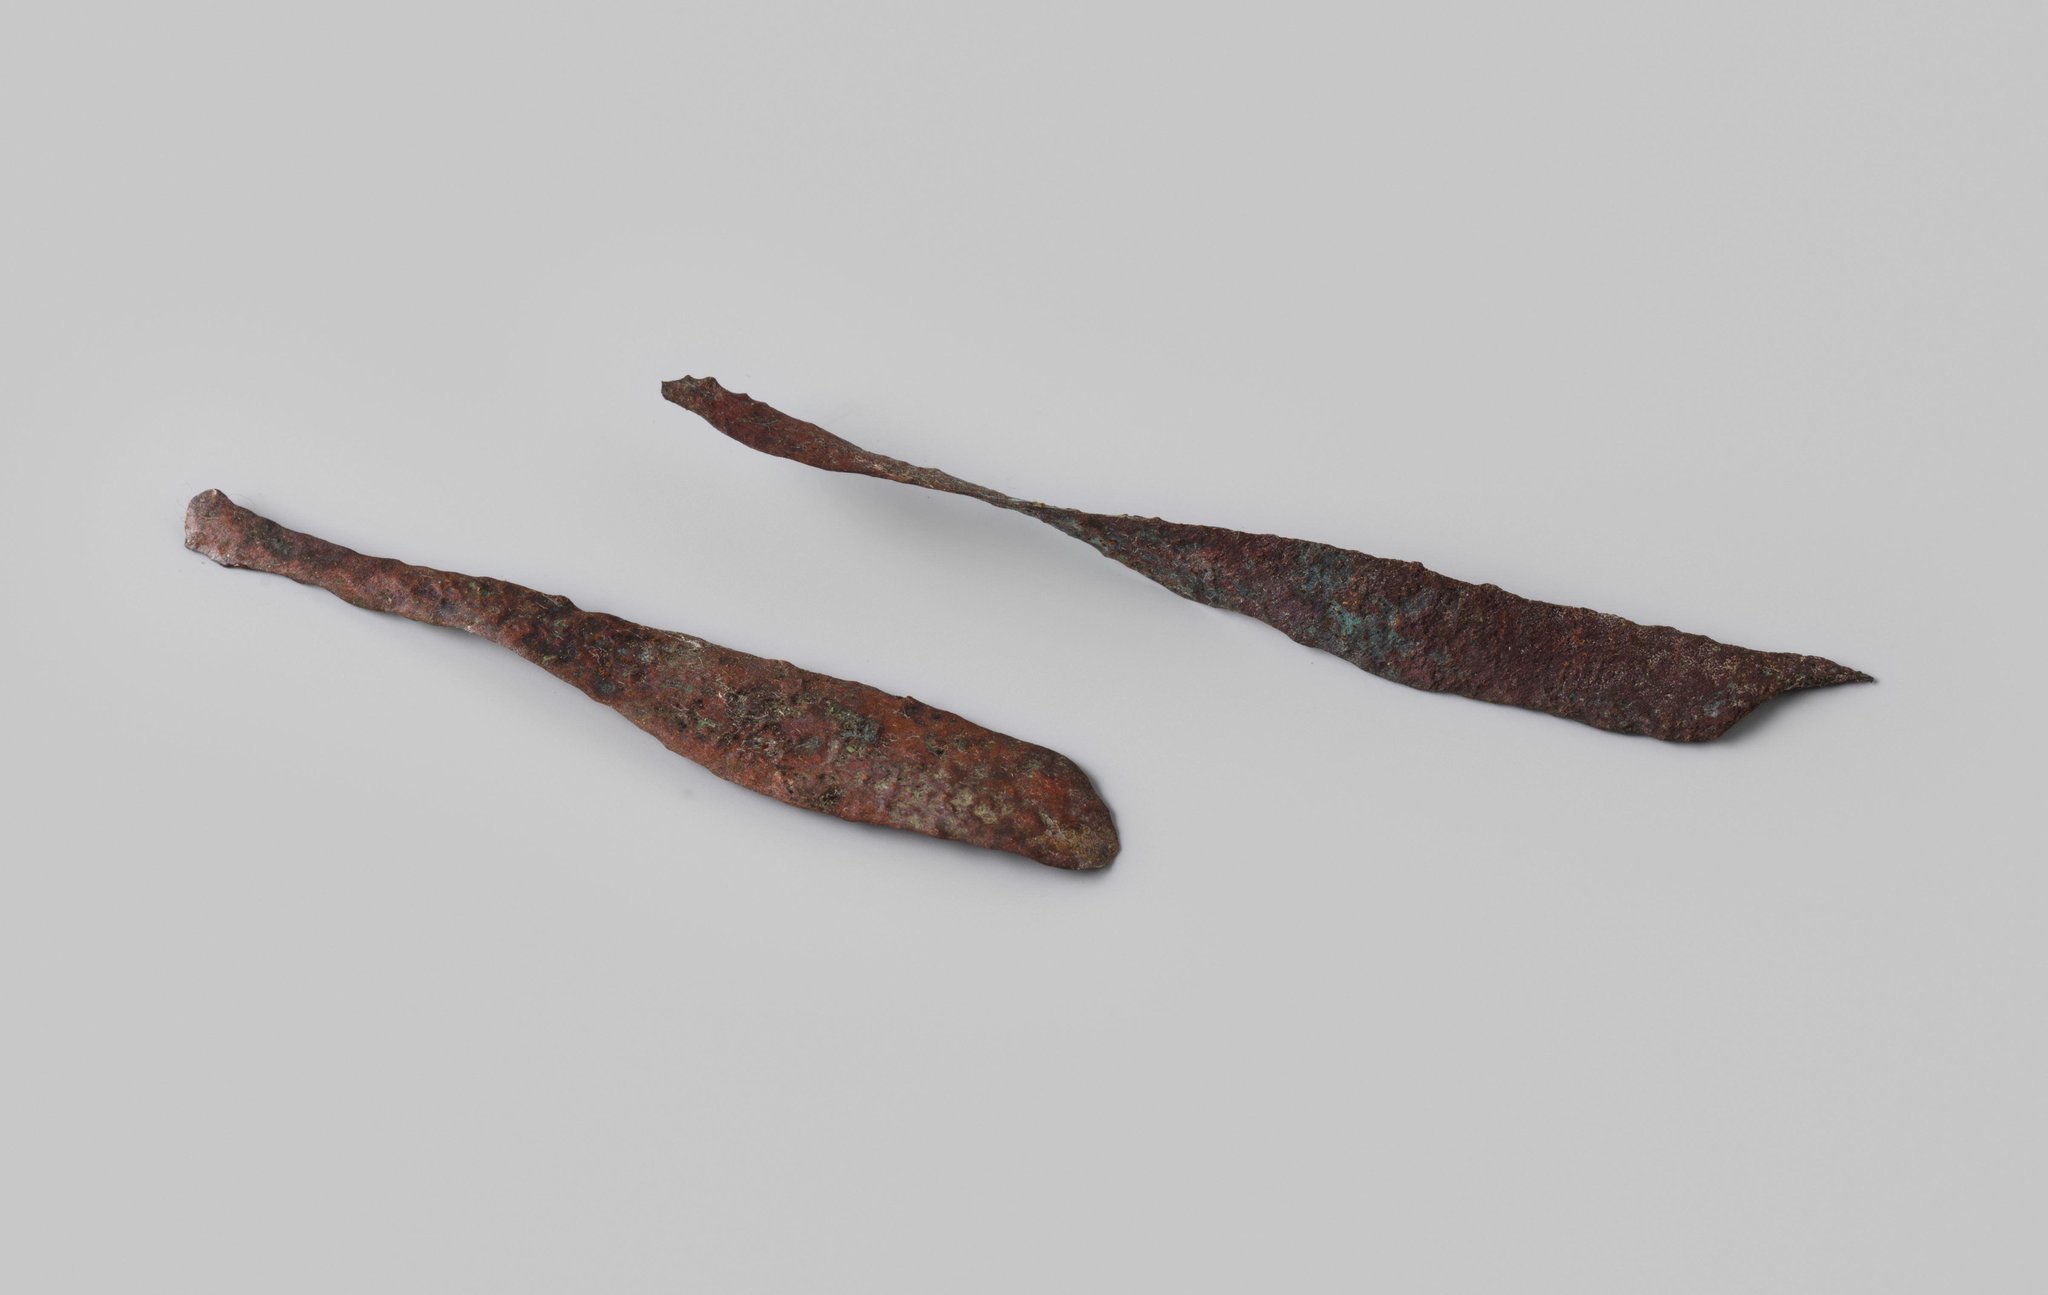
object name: fragment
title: Fragmenten van koper uit het wrak van de Oost-Indiëvaarder Hollandia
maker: Anonymous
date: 1700-1743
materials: copper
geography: netherlands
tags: verenigde oostindische compagnie, hollandia (schip), annet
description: Varied parts or fragments, strips and strip-shaped fragments; fragm.